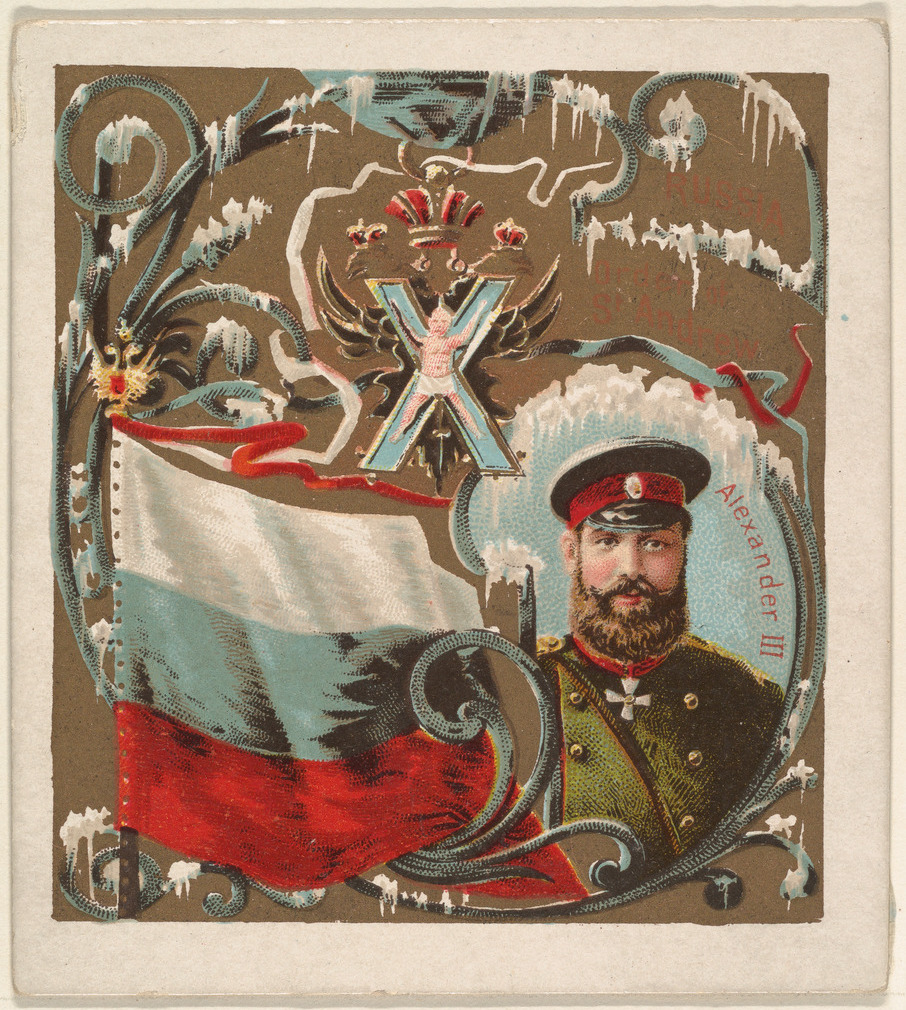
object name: print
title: Russia, from the International Cards series (N238), issued by Kinney Bros.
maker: kinney brothers tobacco company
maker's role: publisher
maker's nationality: american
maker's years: 1869-2011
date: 1888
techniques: color lithograph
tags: soldiers,men,flags